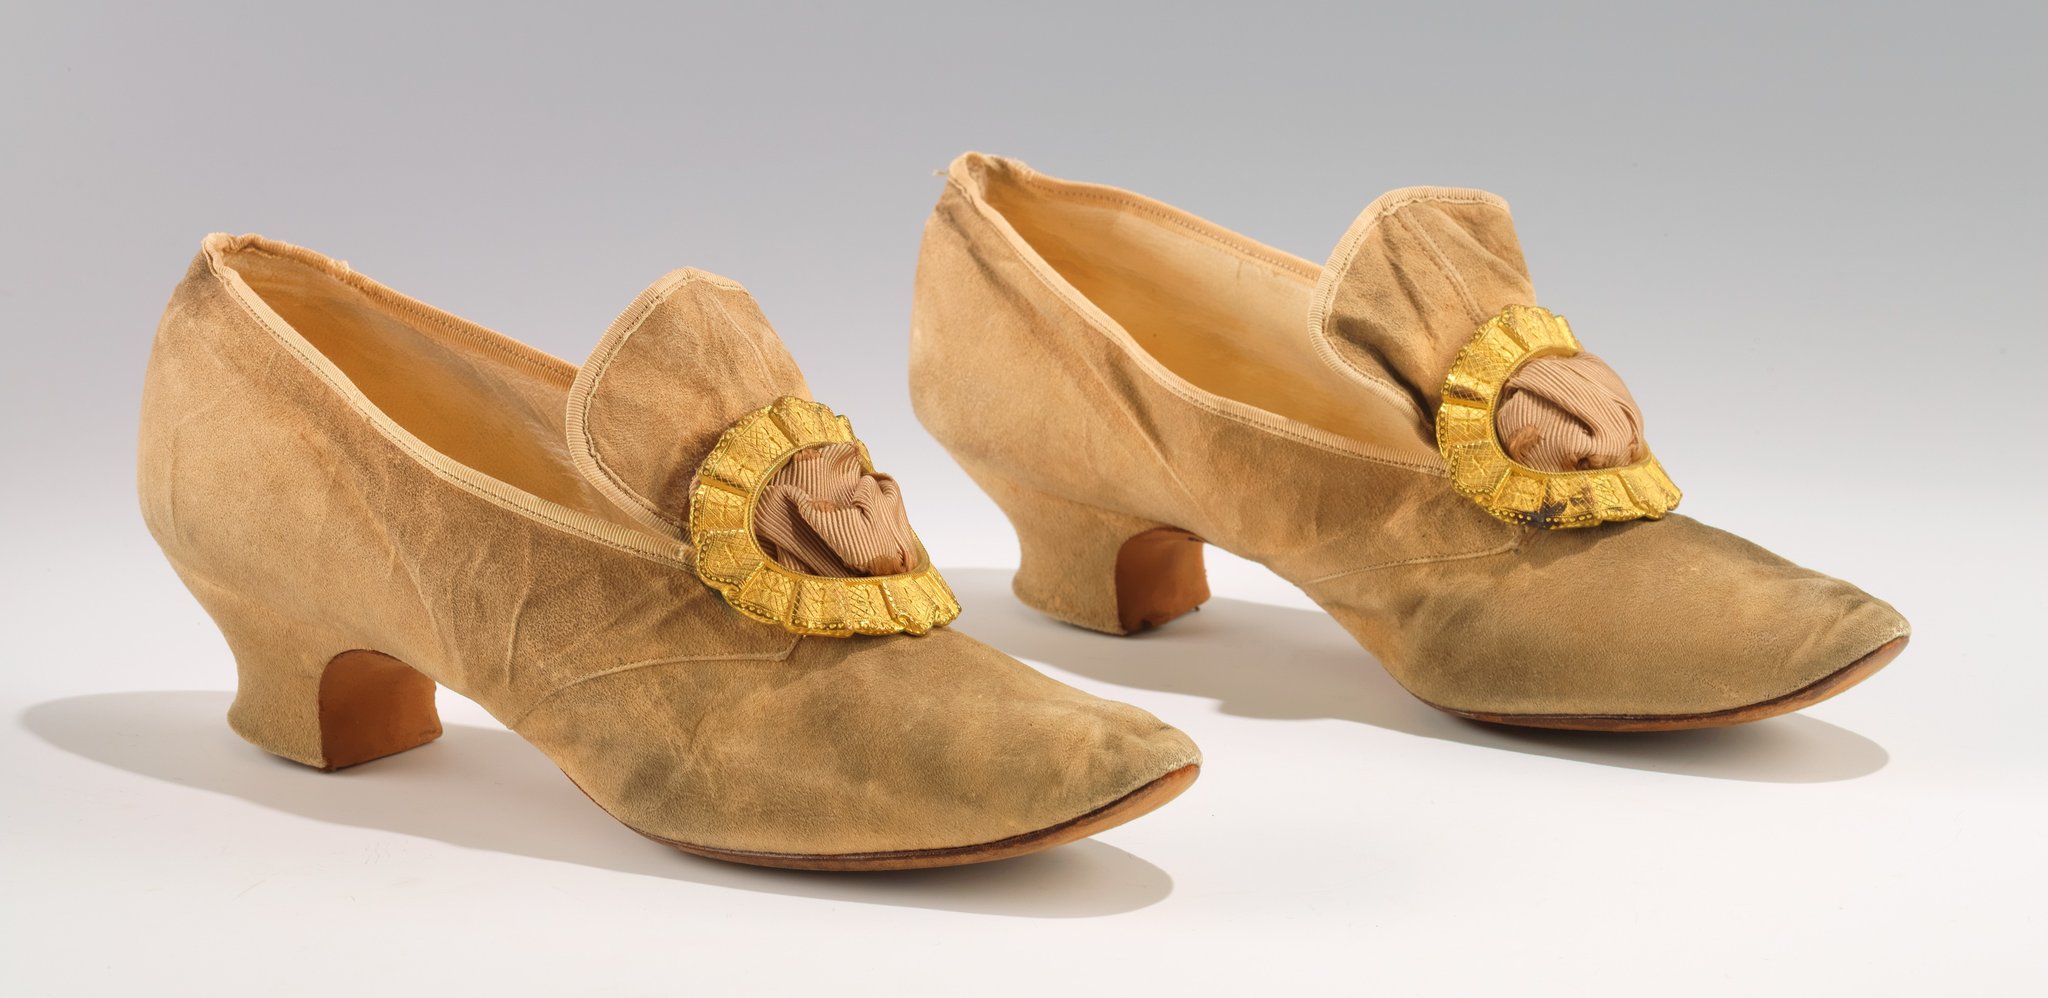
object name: evening pump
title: Evening pumps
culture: american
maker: steigerwalt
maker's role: department store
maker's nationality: american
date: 1890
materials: leather, metal